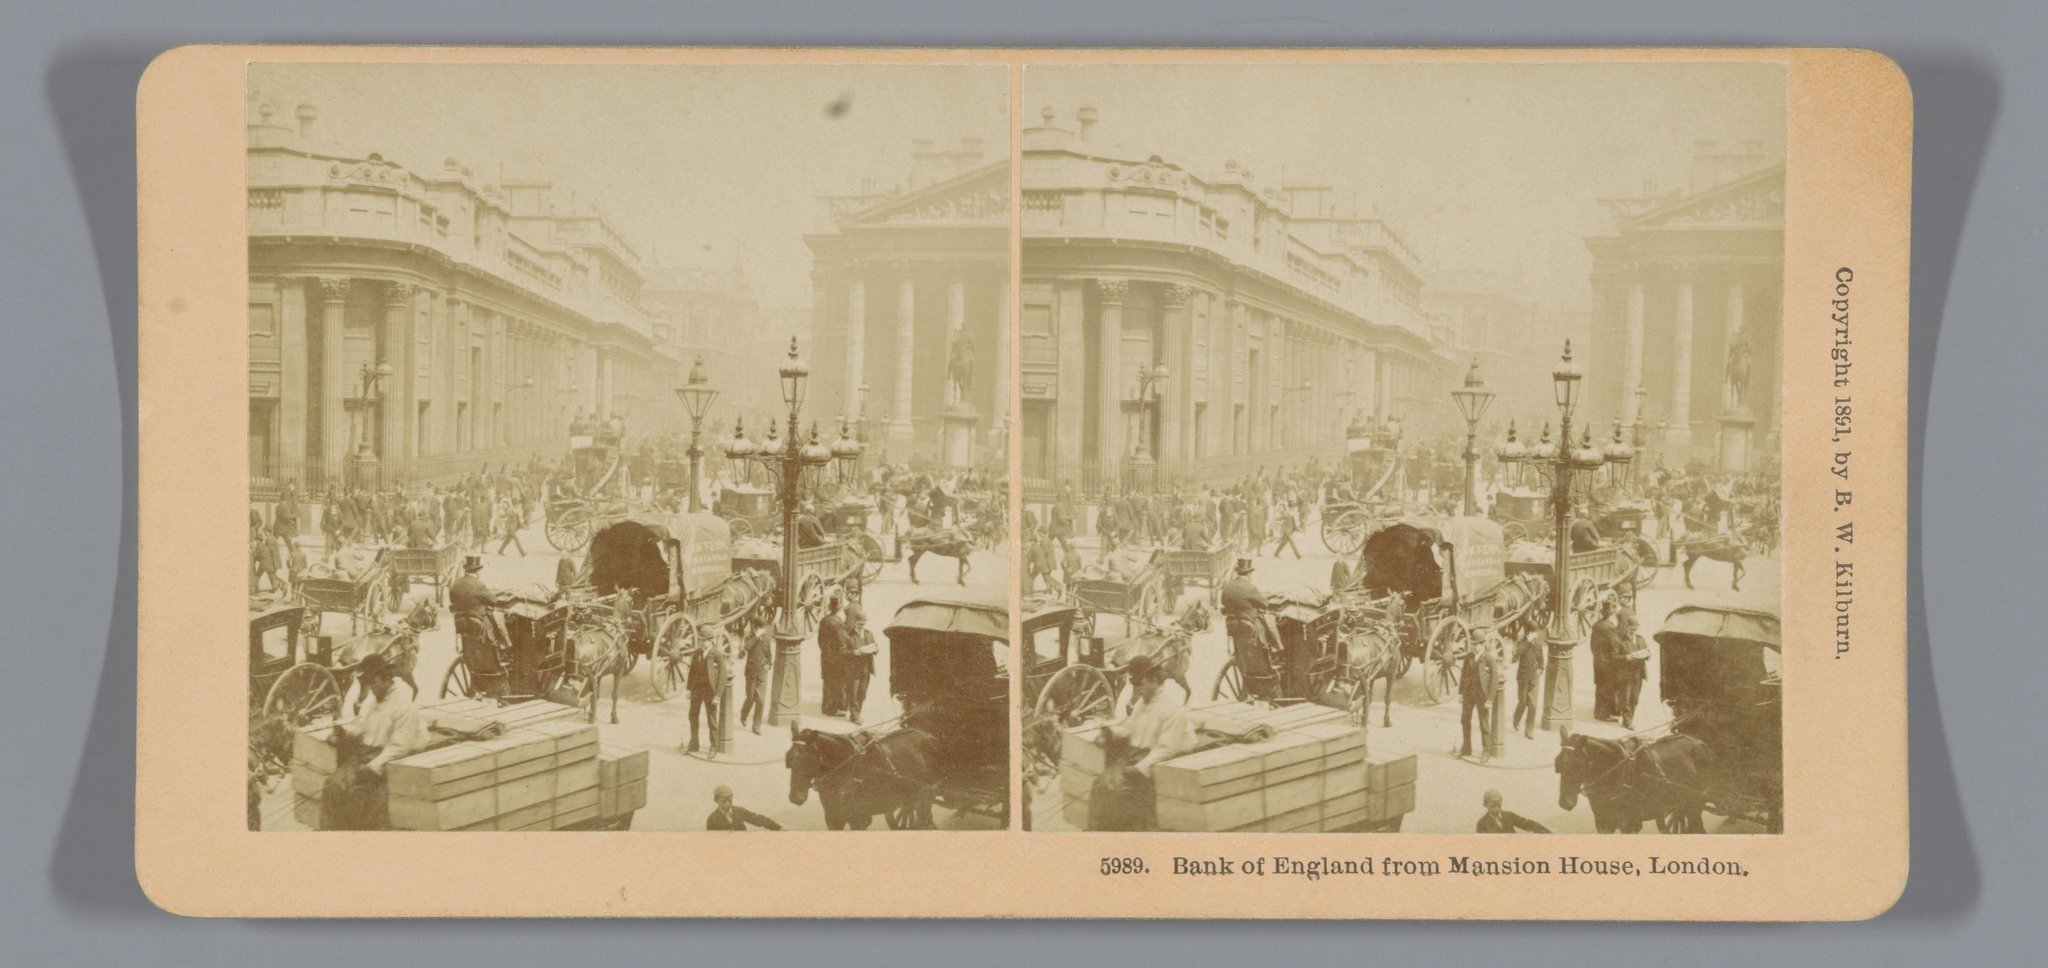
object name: stereograph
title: Bank of England from Mansion House, London.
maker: benjamin west kilburn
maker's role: fotograaf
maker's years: 1827-1909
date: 1891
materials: cardboard, photographic support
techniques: albumen print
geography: littleton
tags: square, place, circus, etc., covered wagon, hooded wagon, façade (of house or building), london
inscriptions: number: ‘5989.’